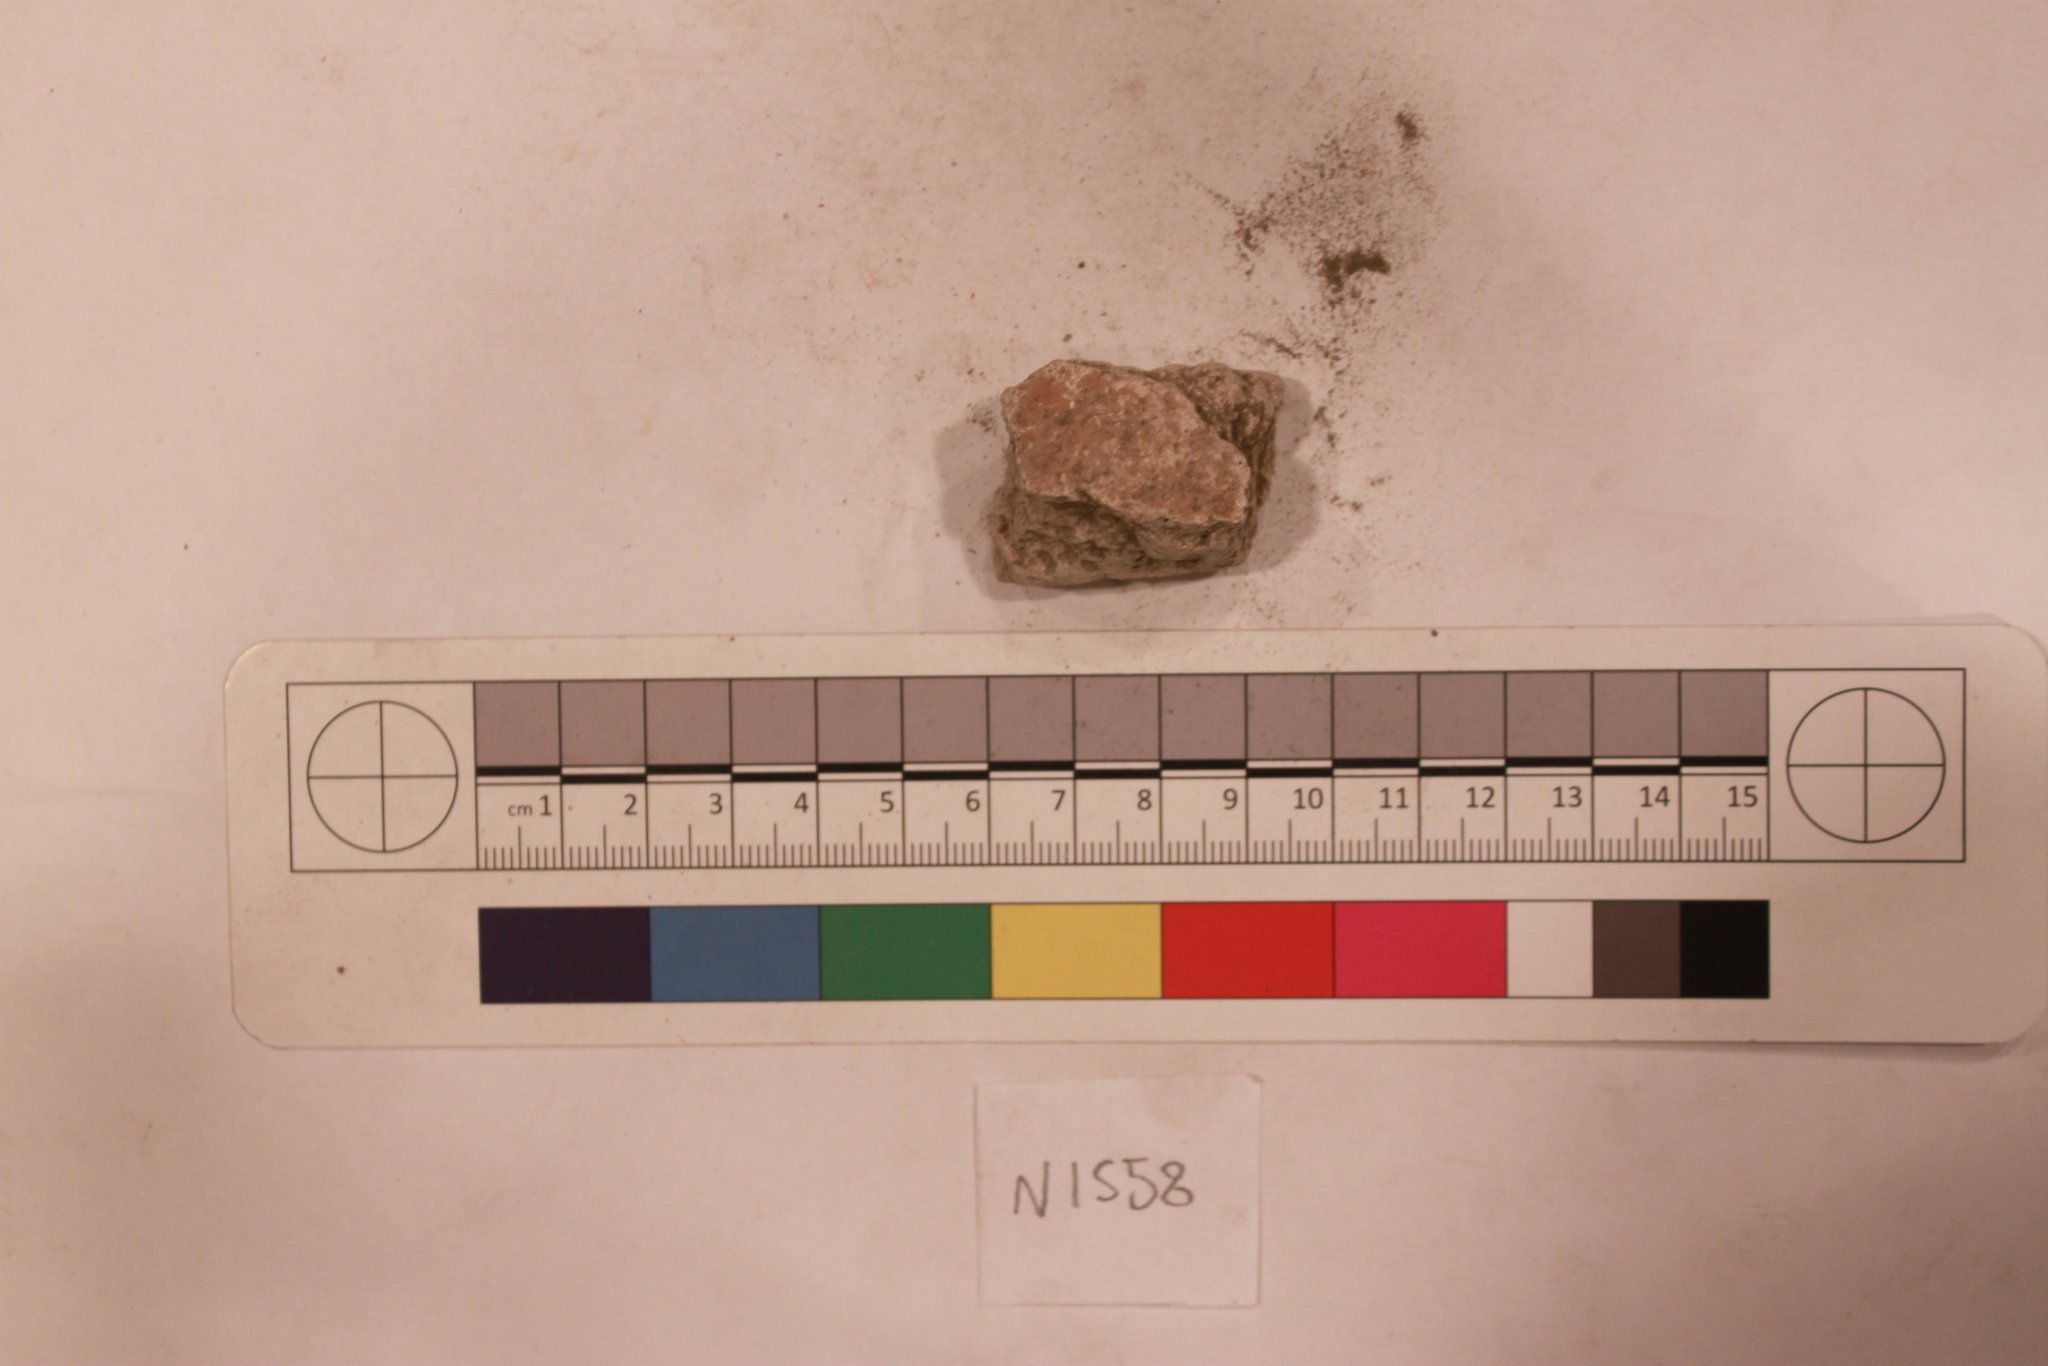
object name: fragment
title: Stucco Fragment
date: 701-1200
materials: plaster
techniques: carving, painting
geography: iran